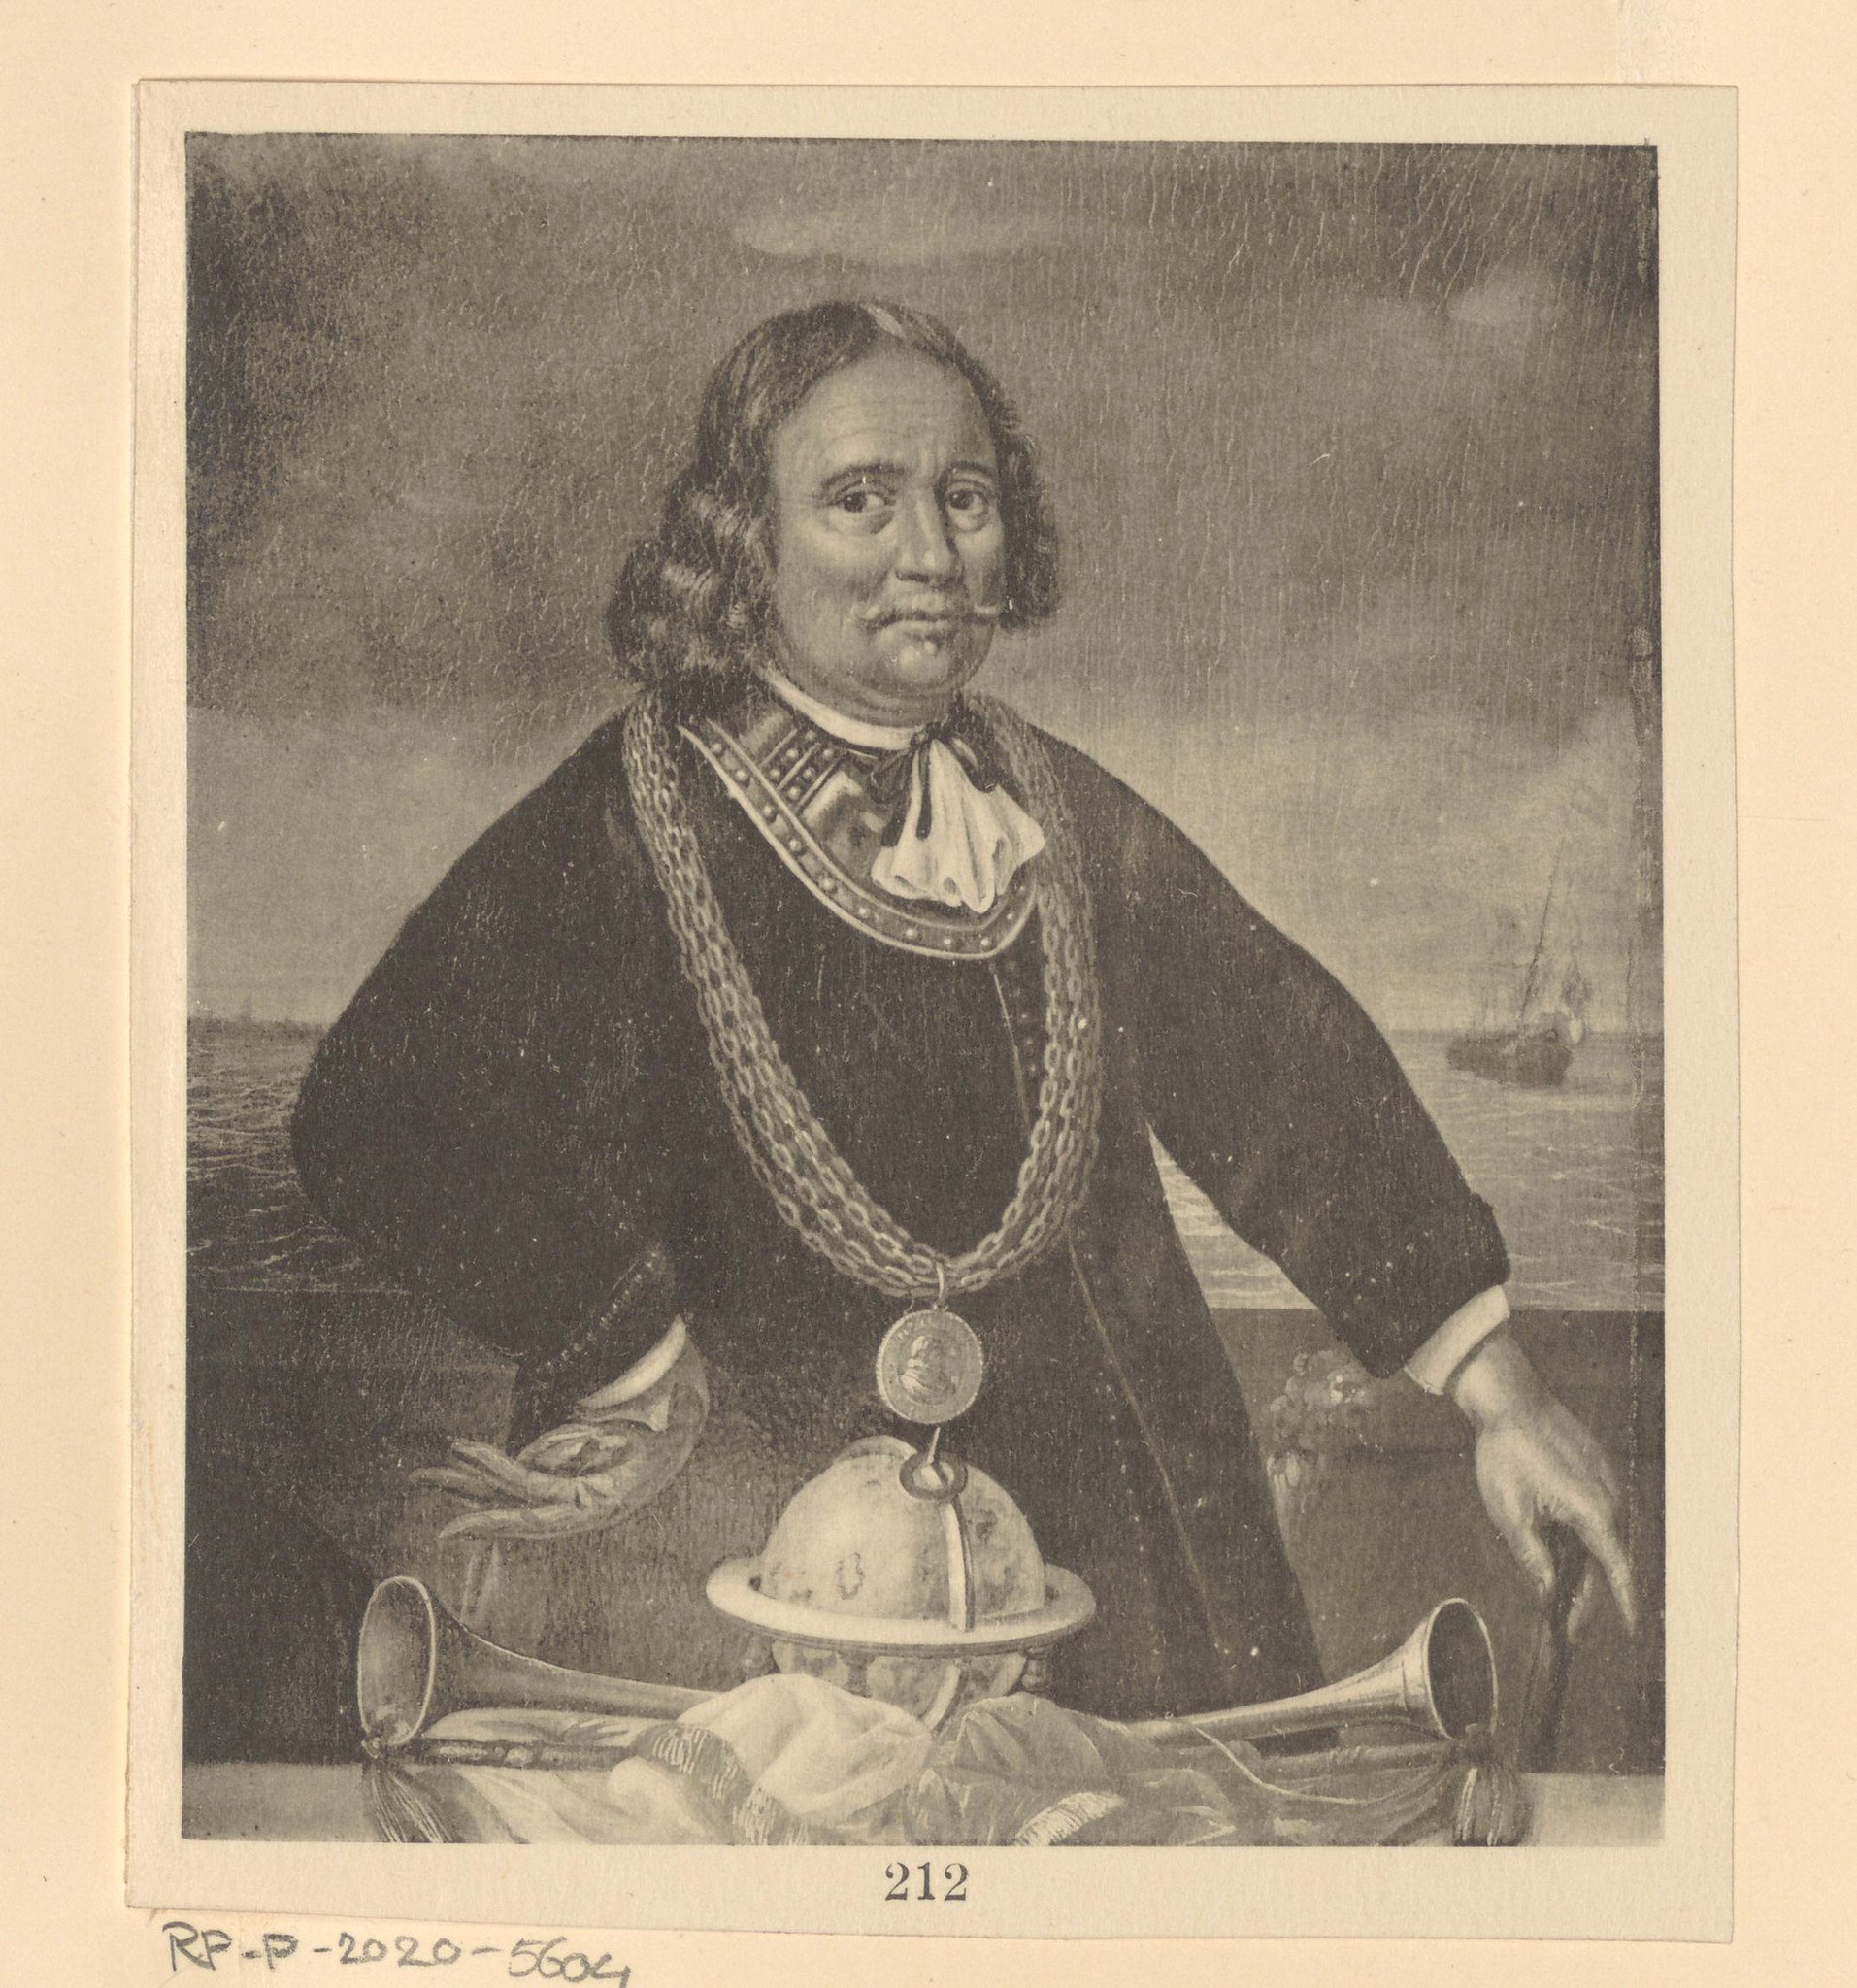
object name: photomechanical print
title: Portret van Egbert Meeusz Kortenaer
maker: Anonymous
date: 1857-1927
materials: paper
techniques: photograph, letterpress printing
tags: historical persons